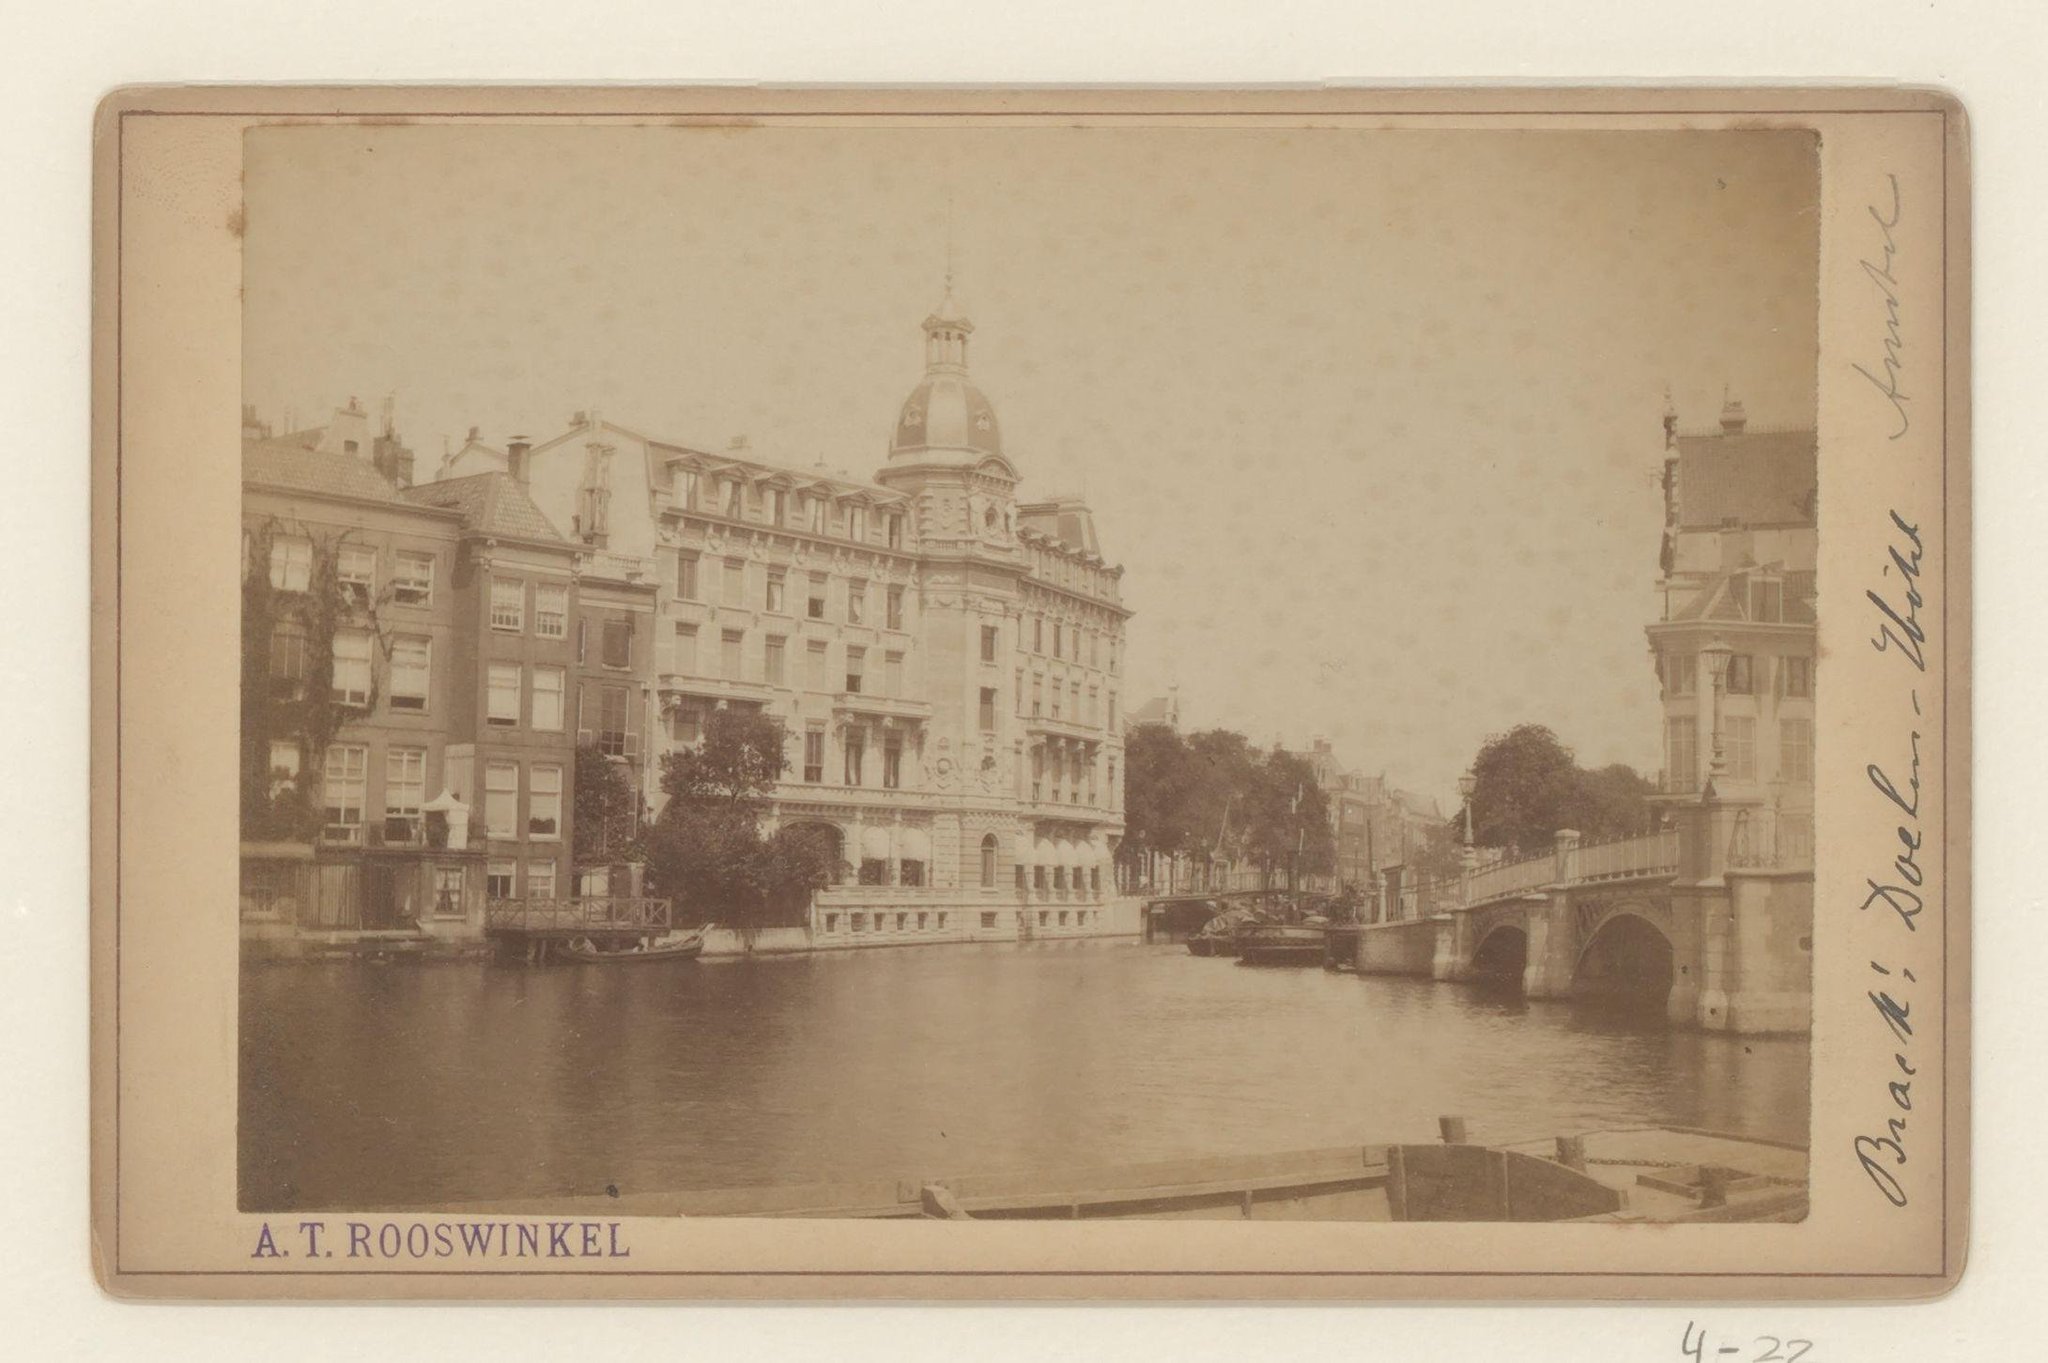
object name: cabinet photograph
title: Gezicht op het Doelenhotel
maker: andreas theodorus rooswinkel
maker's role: fotograaf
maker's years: 1838-1909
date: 1882-1909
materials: cardboard, paper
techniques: albumen print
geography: amsterdam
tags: city-view in general; 'veduta', canal, bridge in city across river, canal, etc., hotel, hostelry, inn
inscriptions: inscription: ‘Brack: Doelen - Hotel Amstel’, collector's mark: ‘4’ Lugt 1641b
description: Onderwerpsrubriek binnen de Atlas Amsterdam: Amstel van Doelensluis tot Blauwbrug.